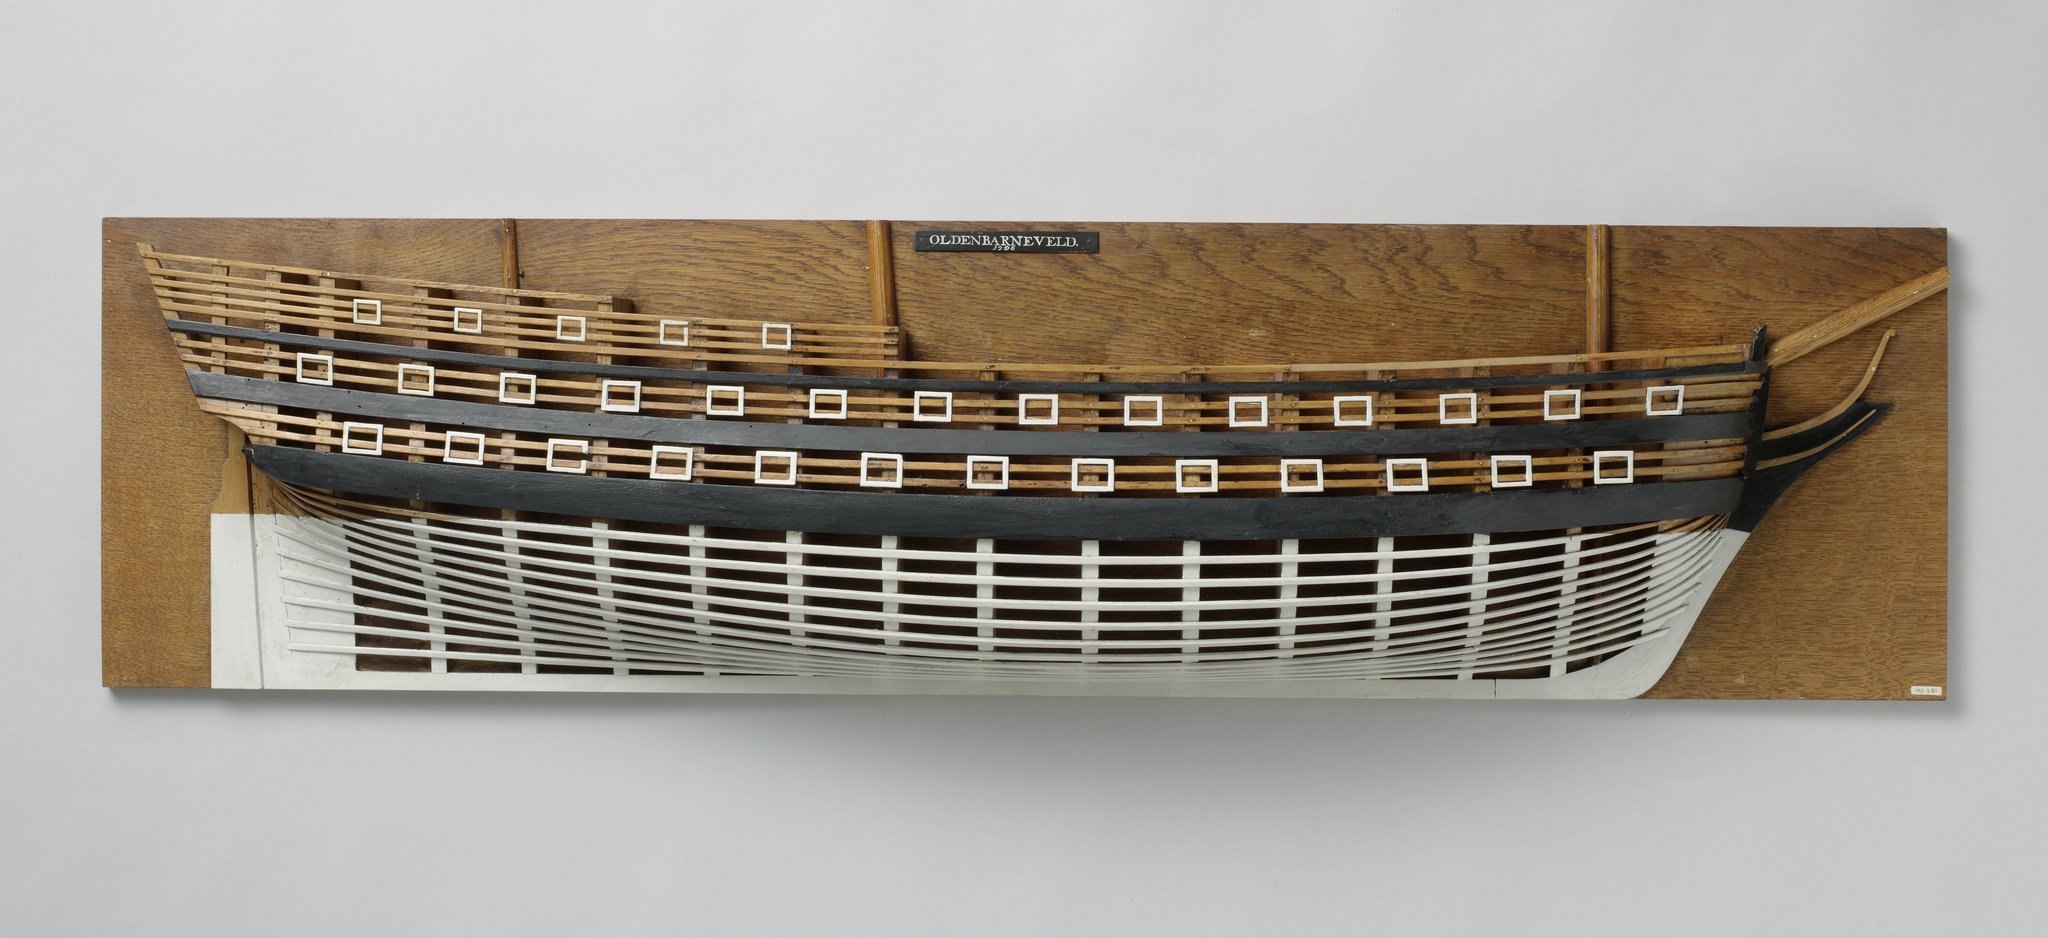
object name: half model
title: Half Model of a 68-Gun Ship of the Line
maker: Anonymous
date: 1796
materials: wood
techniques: polychromy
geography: netherlands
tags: joan van oldenbarneveld (schip)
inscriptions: inscription, top centre, on a square black metal label: ‘OLDENBARNEVELD. / 1796’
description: Gepolychromeerd mallenmodel (stuurboord) van een driemaster. Twee en dertig geschutpoorten verdeeld over drie dekken. Gewrongen spiegel, hol wulf, geen hek of zijgalerij; roer met vierkante roerkoning. Naar achteren oplopende zeeg, twee berghouten en één reehout. Vrij vlak onderwaterschip. Schaal ca. 1:50 (afgeleid).